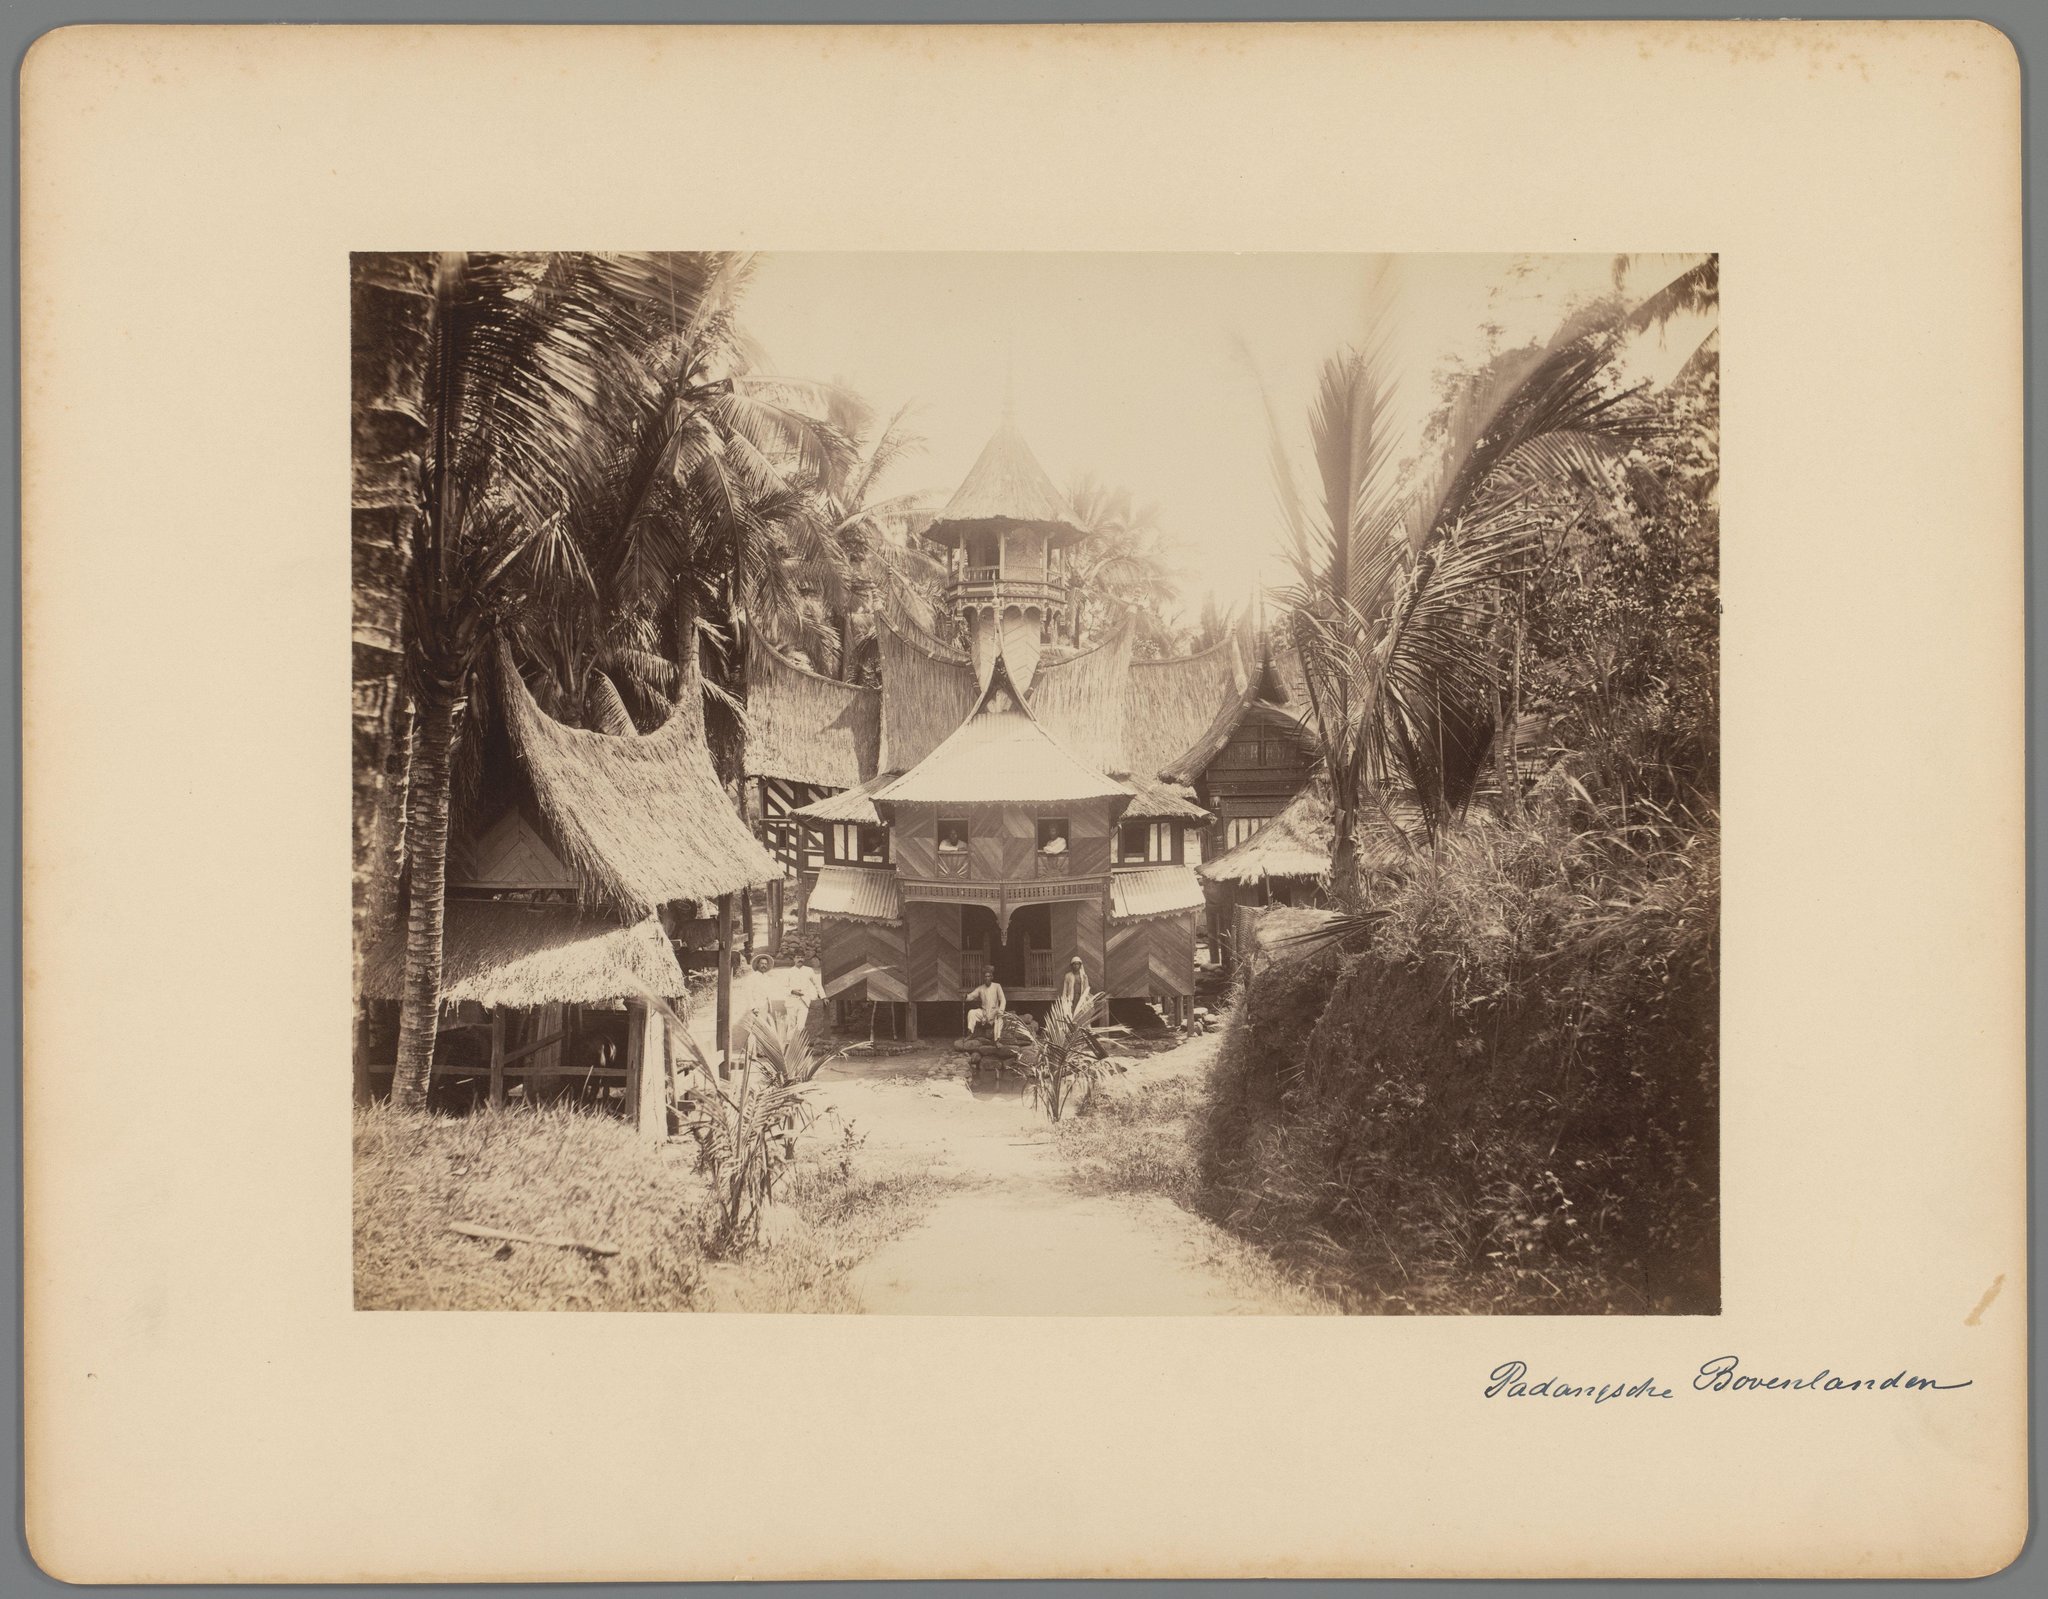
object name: photograph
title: Padangsche Bovenlanden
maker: christiaan benjamin nieuwenhuis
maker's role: publisher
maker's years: 1863-1922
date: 1891-1895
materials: cardboard, paper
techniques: albumen print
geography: sumatera barat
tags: village, temple, shrine ~ islam, mohammedanism, sumatera barat (province)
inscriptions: inscription: ‘Foto’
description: Deze foto zat oorspronkelijk in prentenkabinet RP-F-AA3192.